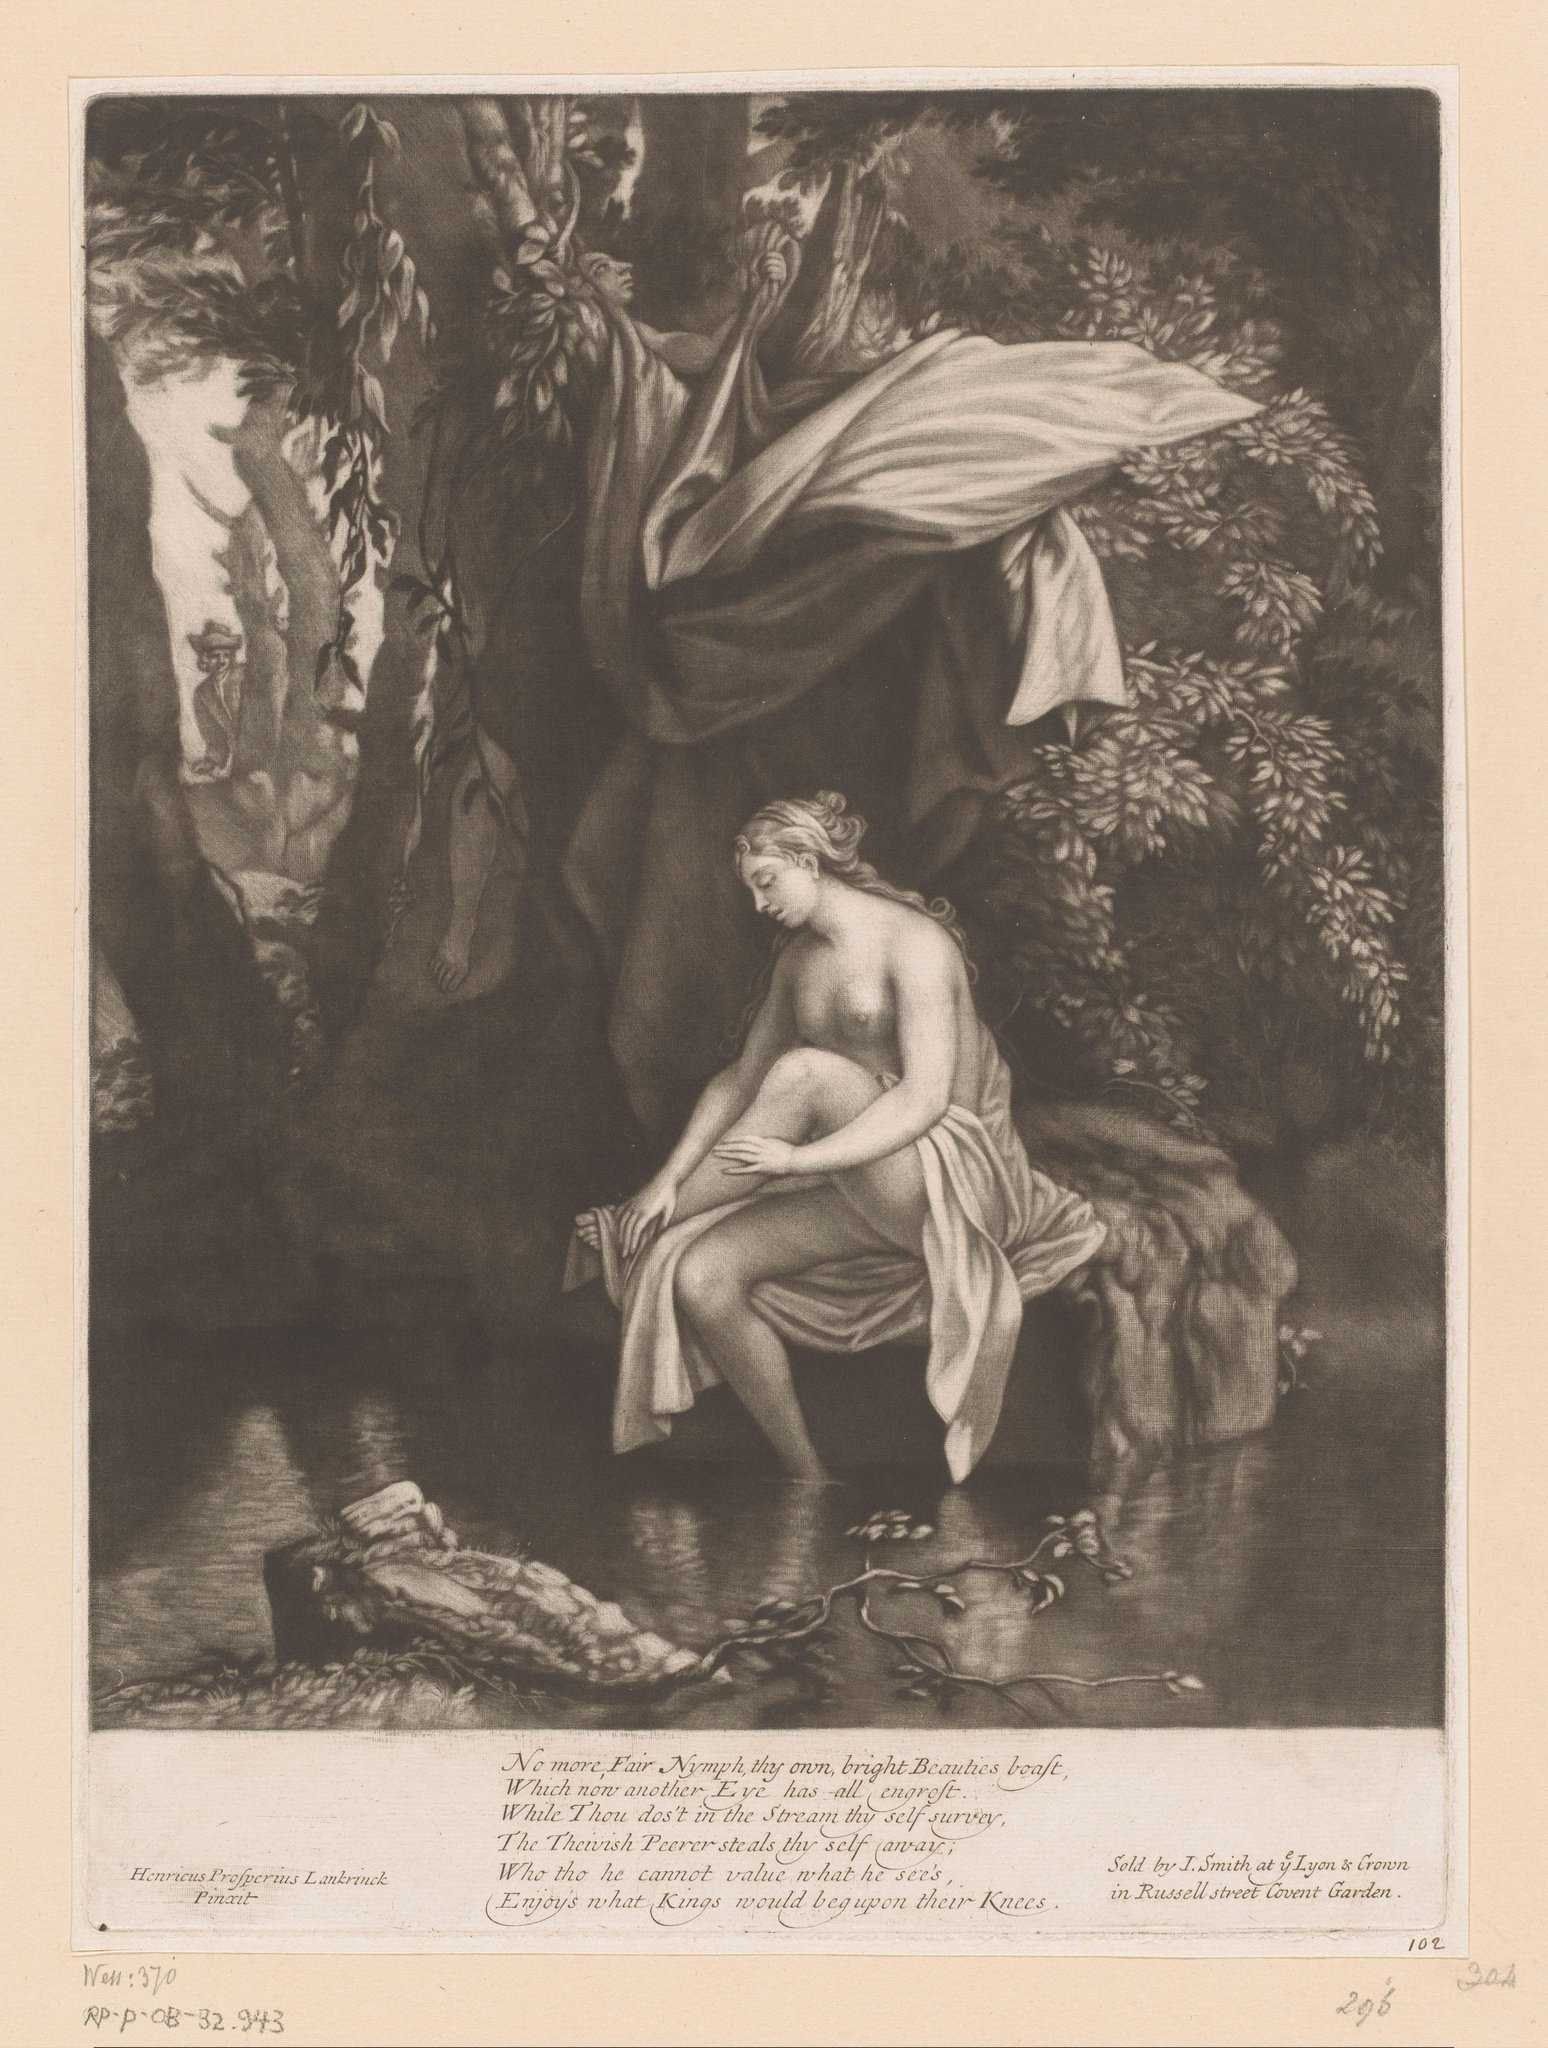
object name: print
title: Badende nimf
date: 1662-1742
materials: paper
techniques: mezzotint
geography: london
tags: other types of nymph(s), public baths - aa - in the open air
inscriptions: collector's mark: Lugt 240